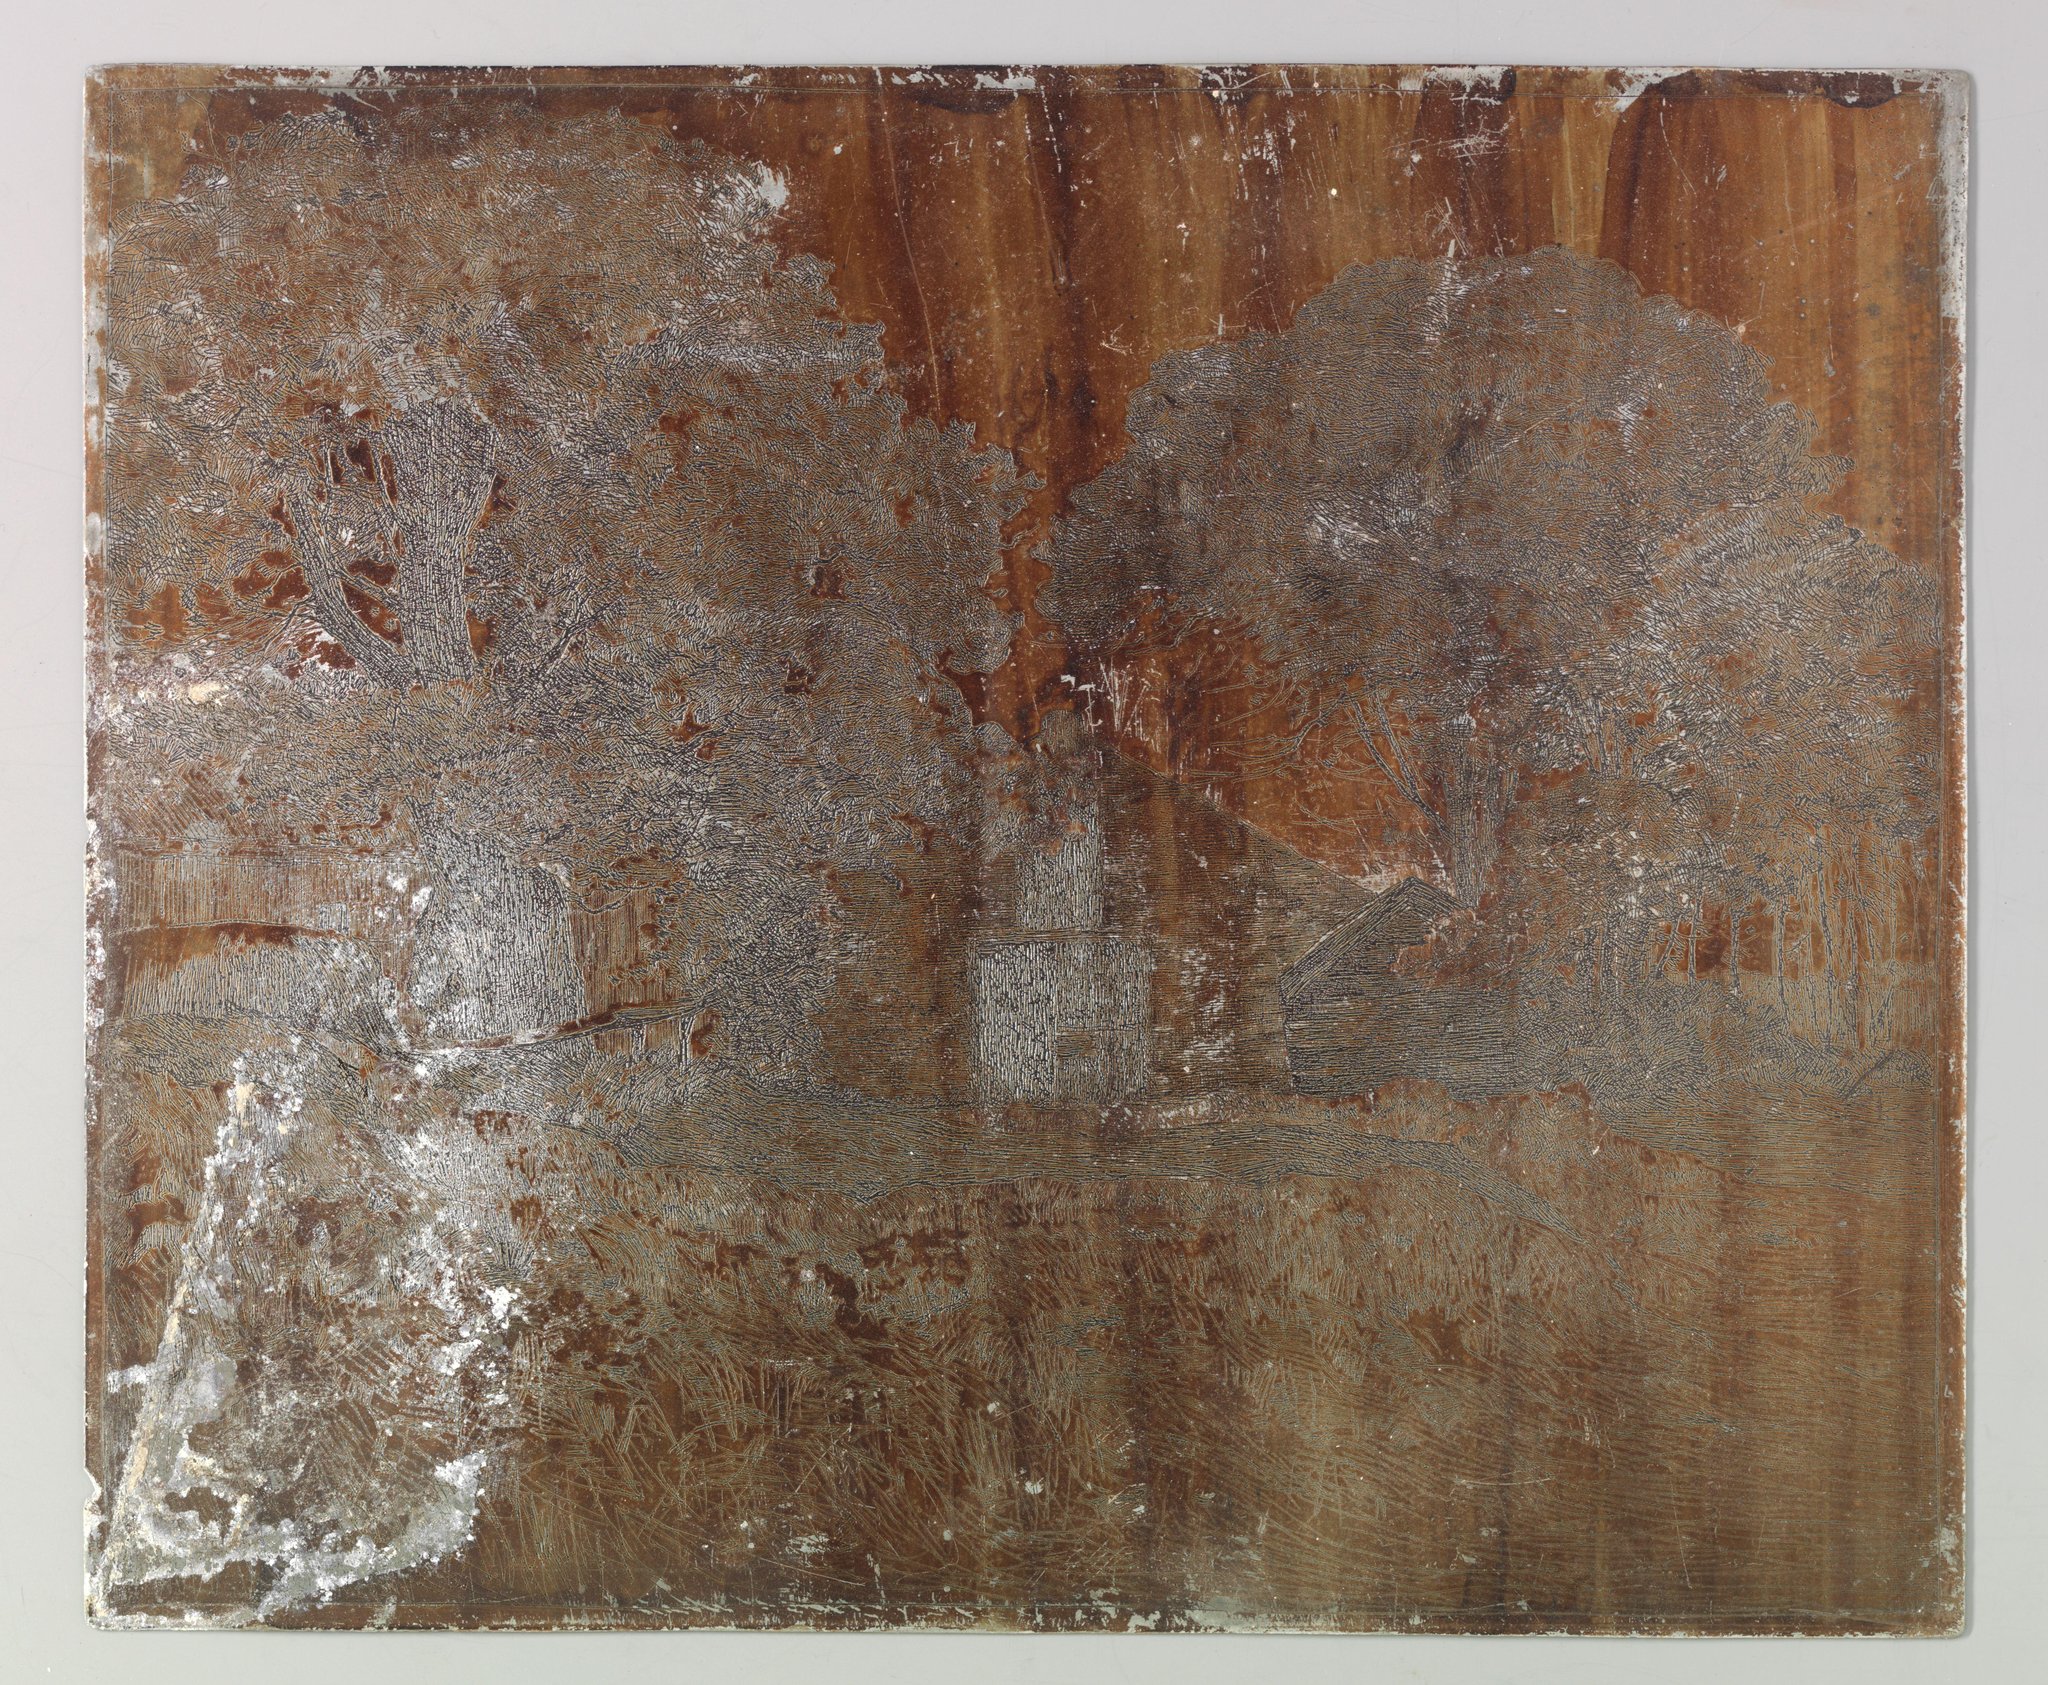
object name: zinkplaat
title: Landschap met boerderij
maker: willem de zwart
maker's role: draughtsman, painter, print maker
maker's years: 1862-1931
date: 1885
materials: zinc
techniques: etching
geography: netherlands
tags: farm or solitary house in landscape